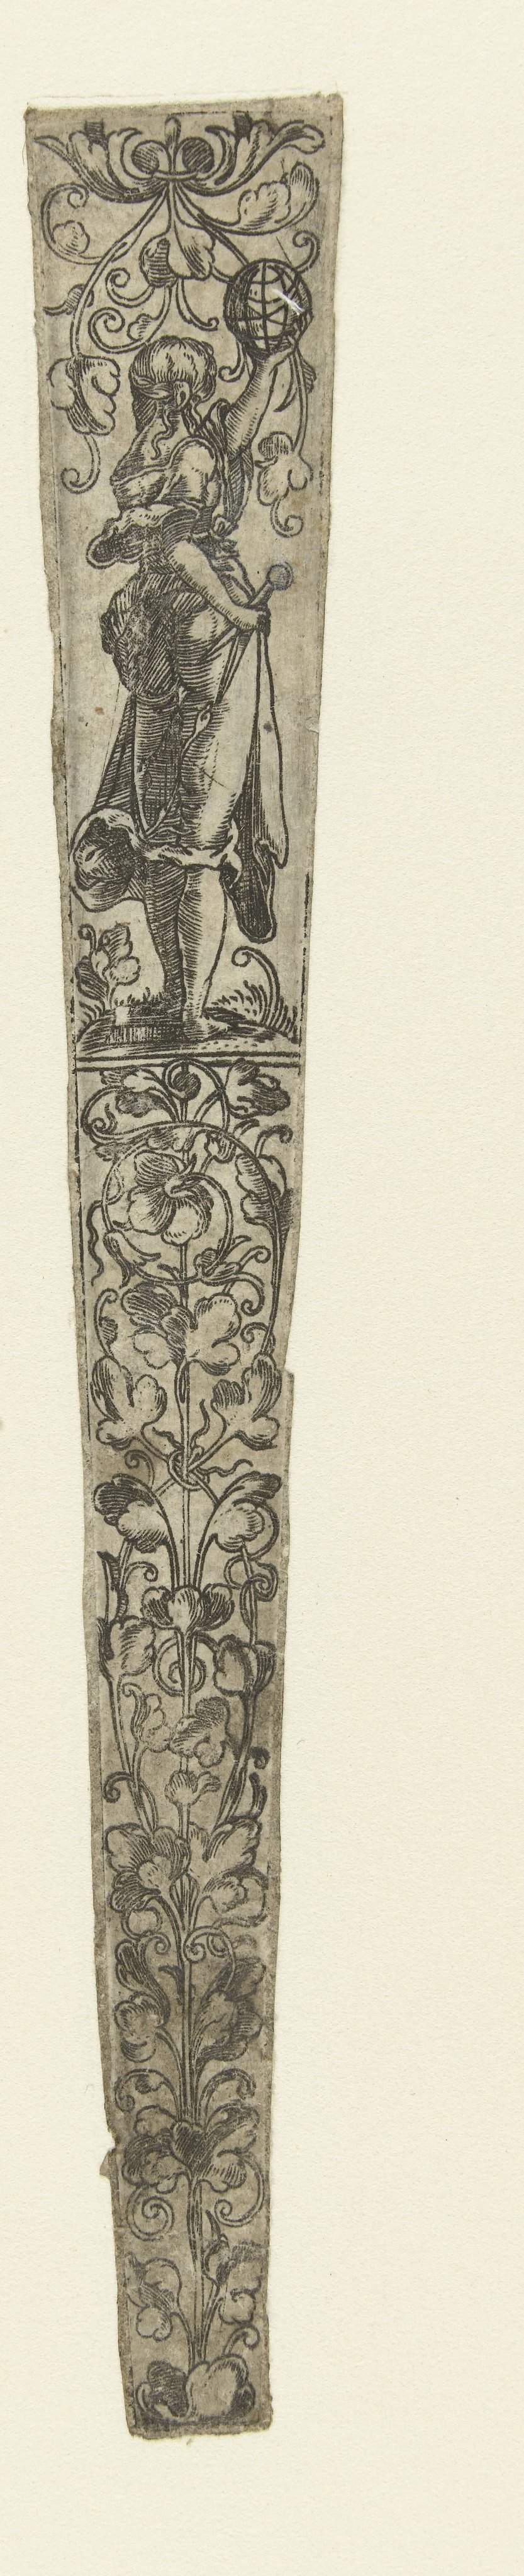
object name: print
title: Schede met bovenaan een vrouw op de rug gezien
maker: Anonymous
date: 1500-1600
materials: paper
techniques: engraving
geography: germany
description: De vrouw houdt een passer en een wereldbol vast (Geometria?). Het onderste gedeelte is gedecoreerd met bladranken.